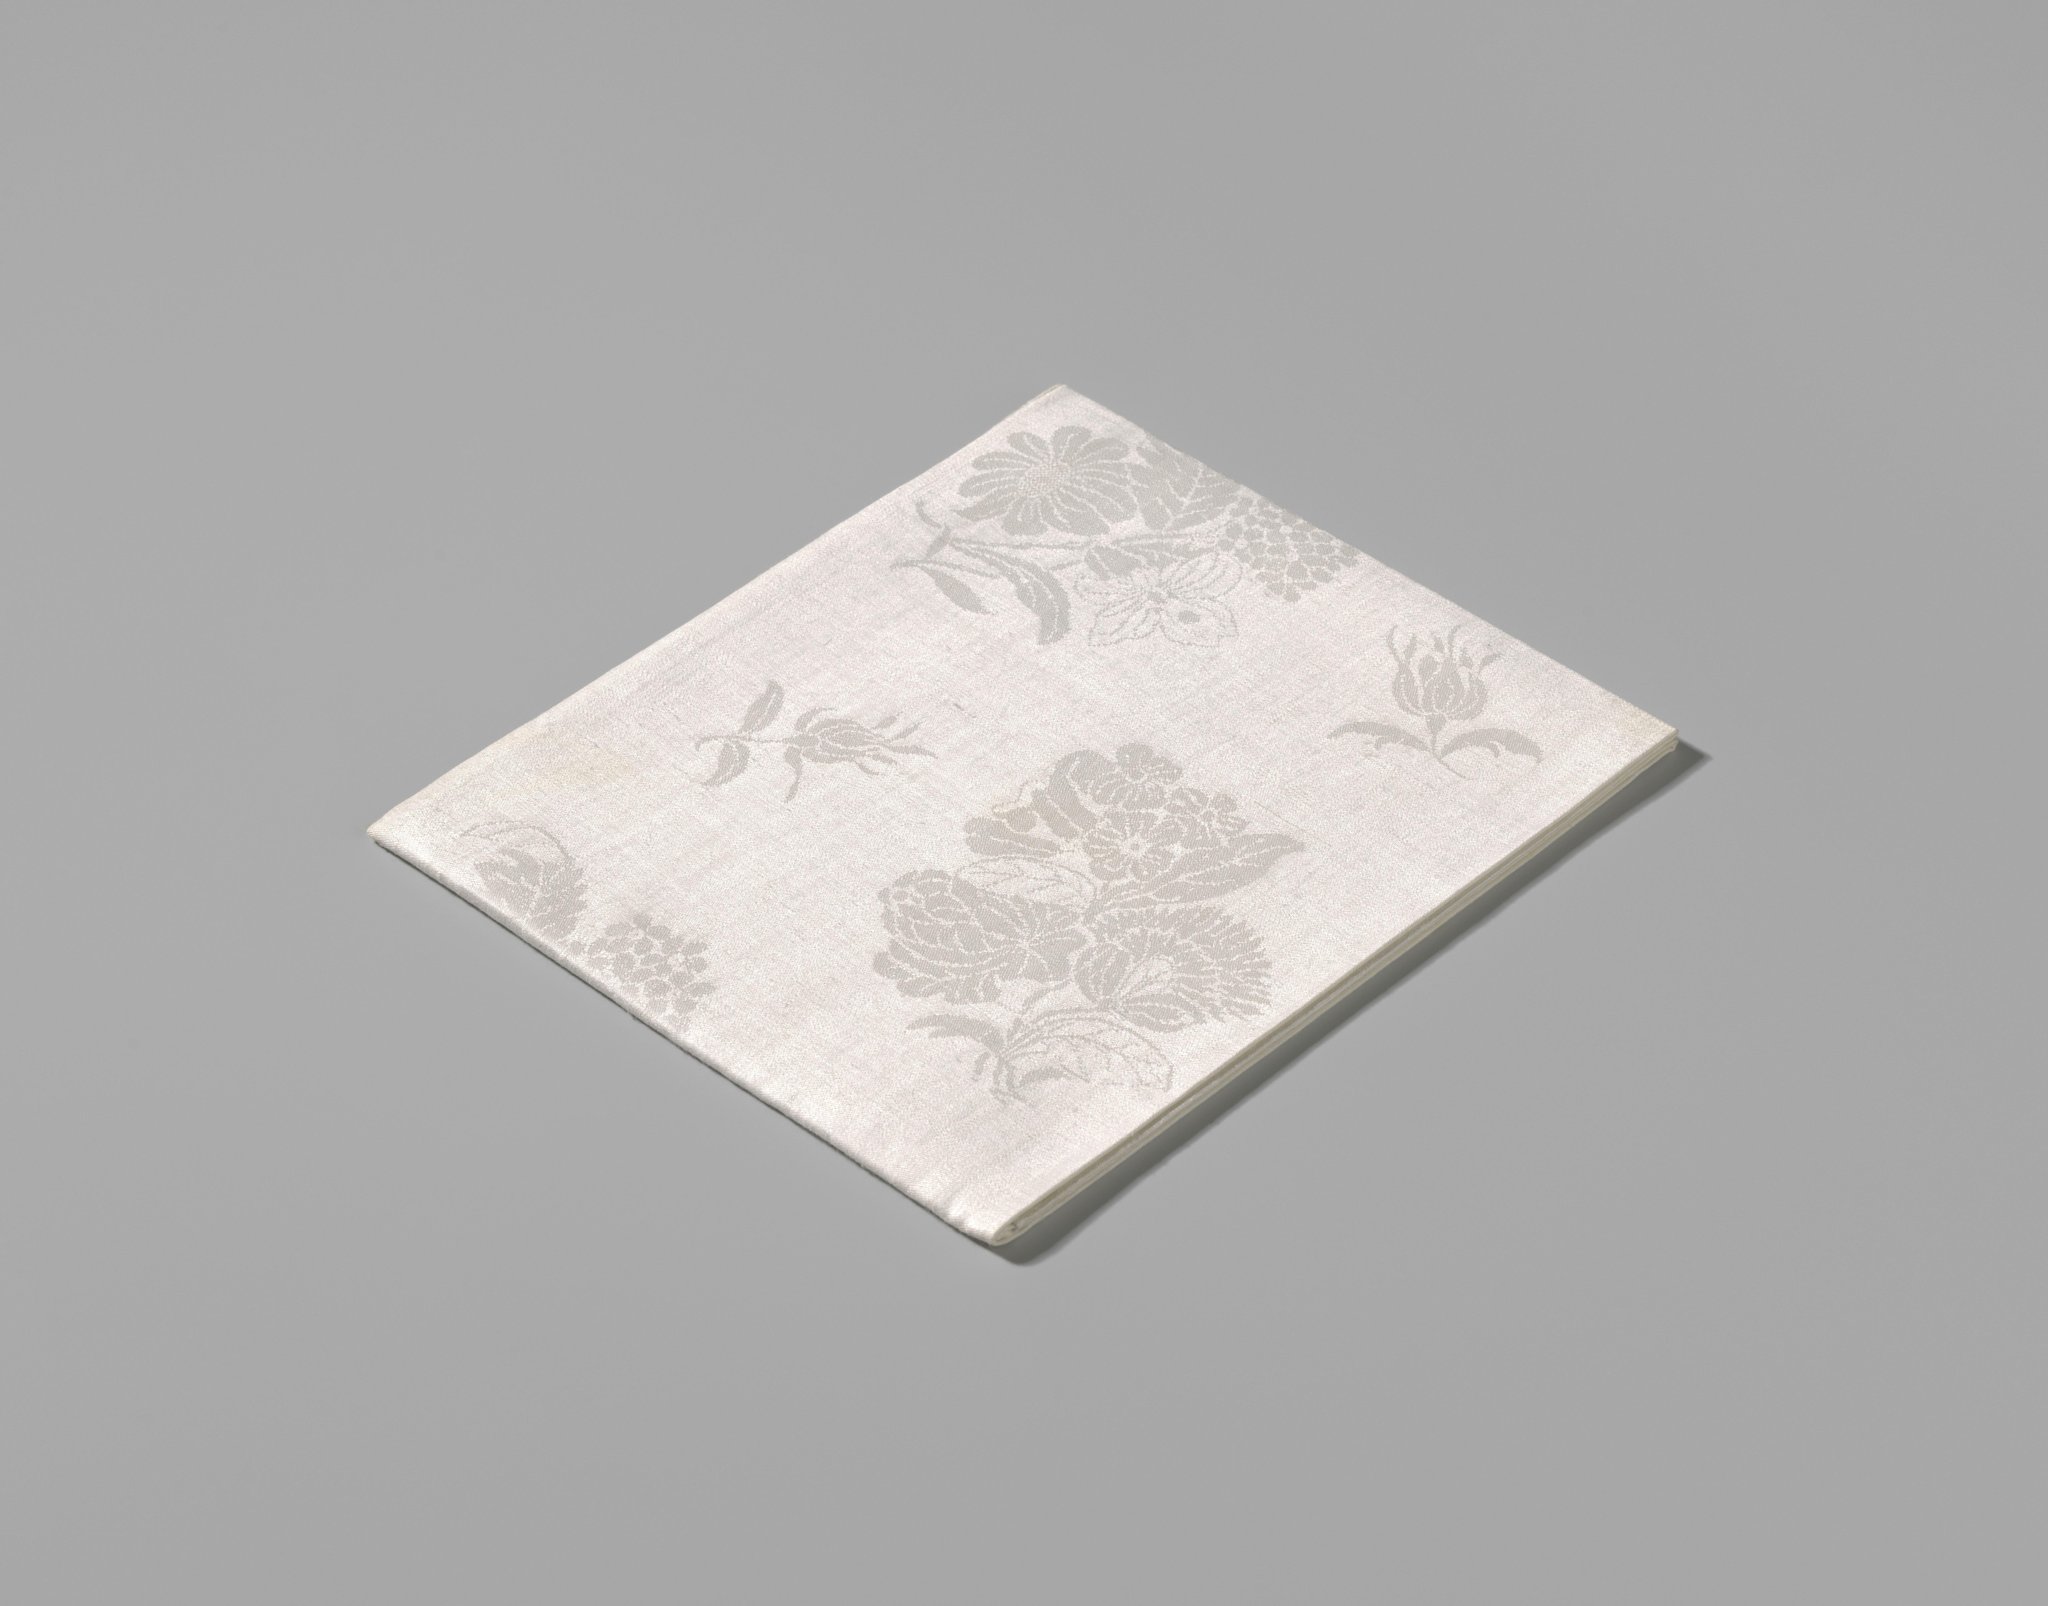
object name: napkin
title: Servet van wit linnendamast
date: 1831-1850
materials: linen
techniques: damask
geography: northern netherlands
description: Wit linnen damasten servet met bloemtakken en bloemenrand. Merk HW 12